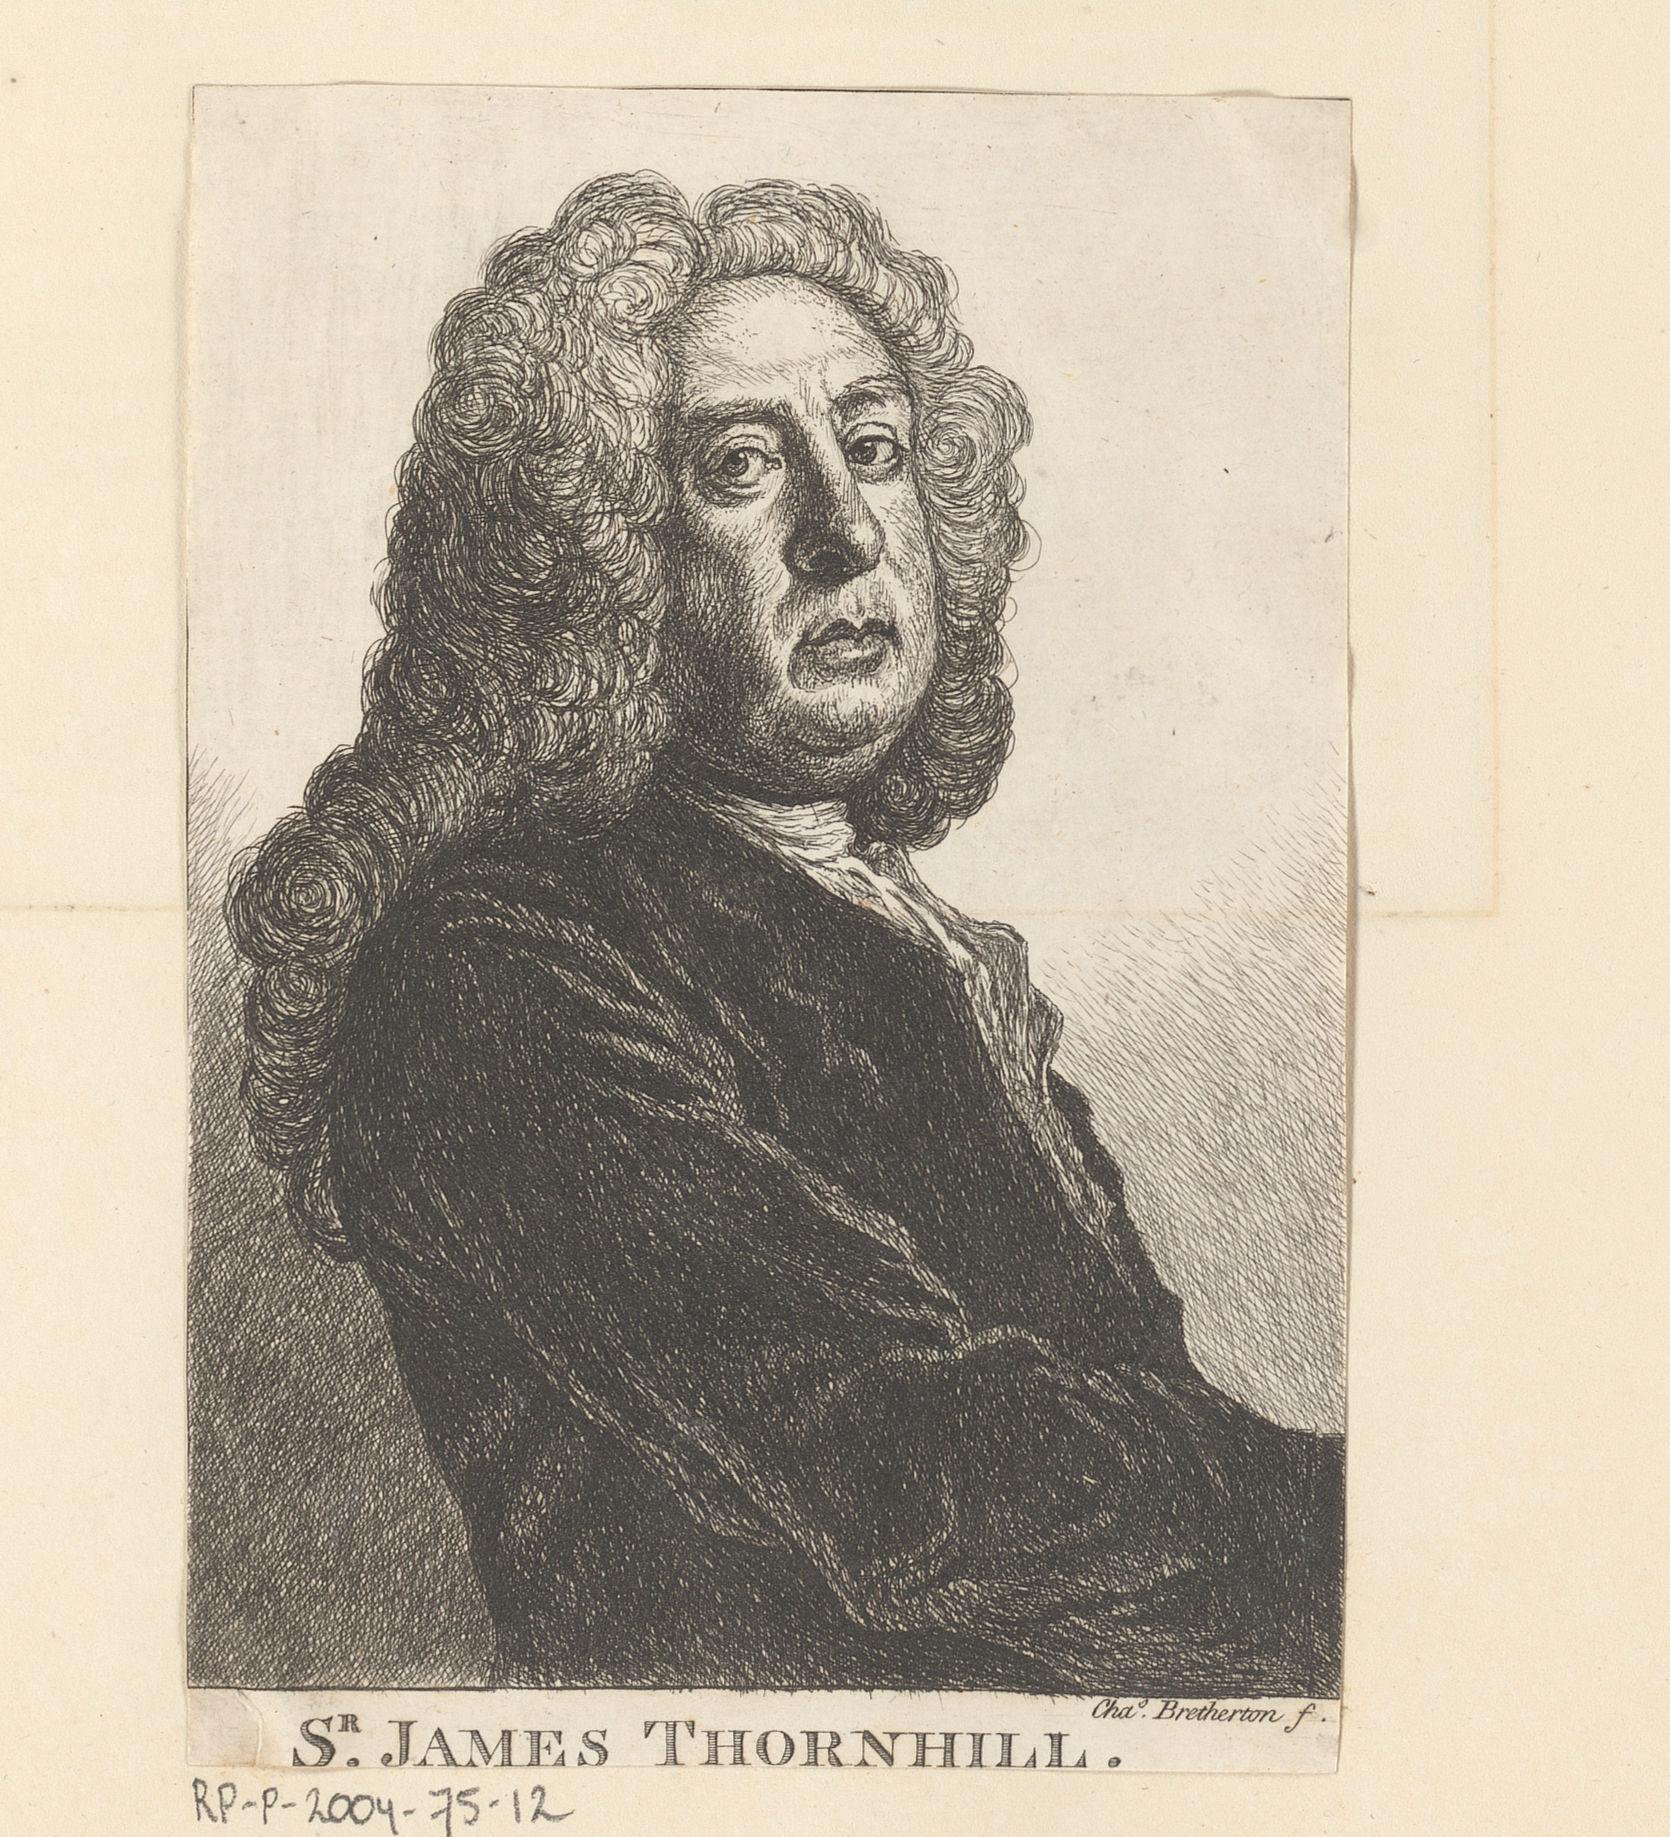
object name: album leaf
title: Portret van James Thornhill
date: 1730-1762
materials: paper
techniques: etching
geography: london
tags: james thornhill, historical persons, portrait, self-portrait of painter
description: Prent uit: Walpole, Horace. Anecdotes of painting in England with some account of the principal artists and incidental notes on other arts collected by the late Mr. George Vertue and now digested and published from his original Mss. by Horace Walpole. 4 dln. Londen: Horace Walpole, [1762-1789], dl. 4, p. 20. De samensteller heeft deze prent in het album geplakt als illustratie bij: Pilkington, Matthew en Johann Heinrich Füssli. A dictionary of painters, from the revival of the art to the present period. 4 dln. Londen: John Crowder, 1805, dl. 4, p. 557.